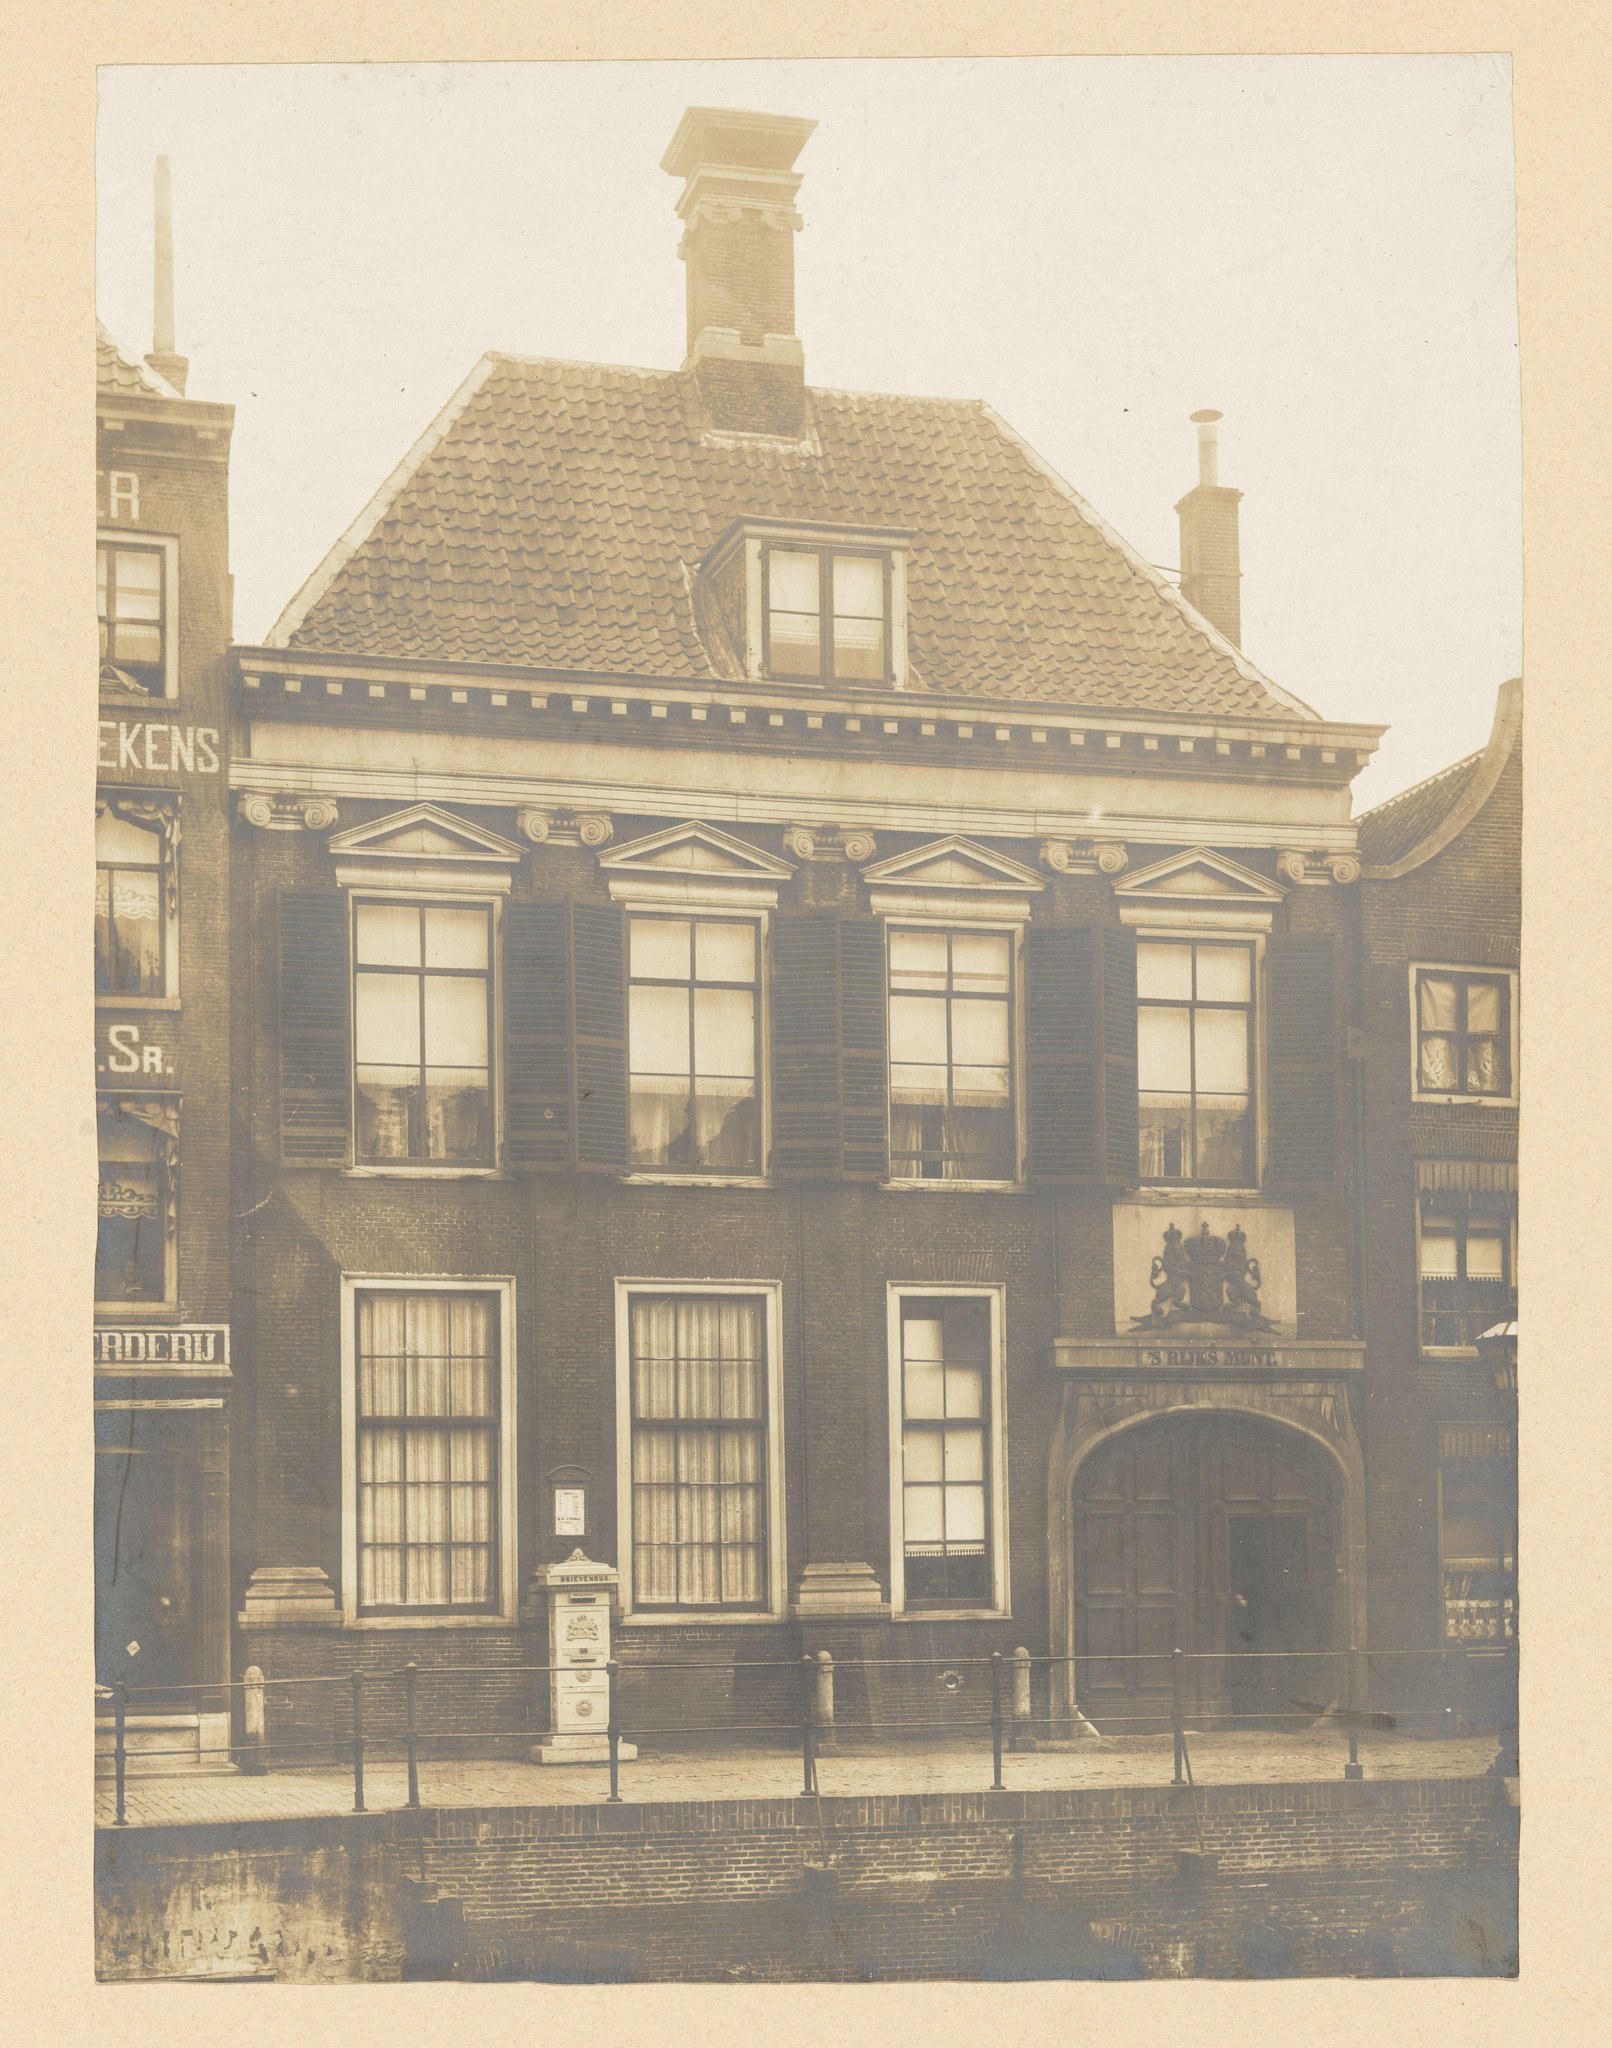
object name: photograph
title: Façade van pand te Utrecht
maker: anoniem (monumentenzorg)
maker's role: fotograaf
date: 1909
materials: cardboard, photographic support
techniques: gelatin silver print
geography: utrecht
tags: façade (of house or building), utrecht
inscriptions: annotation: ‘Muntgebouw te Utrecht/ 17 december 1909’